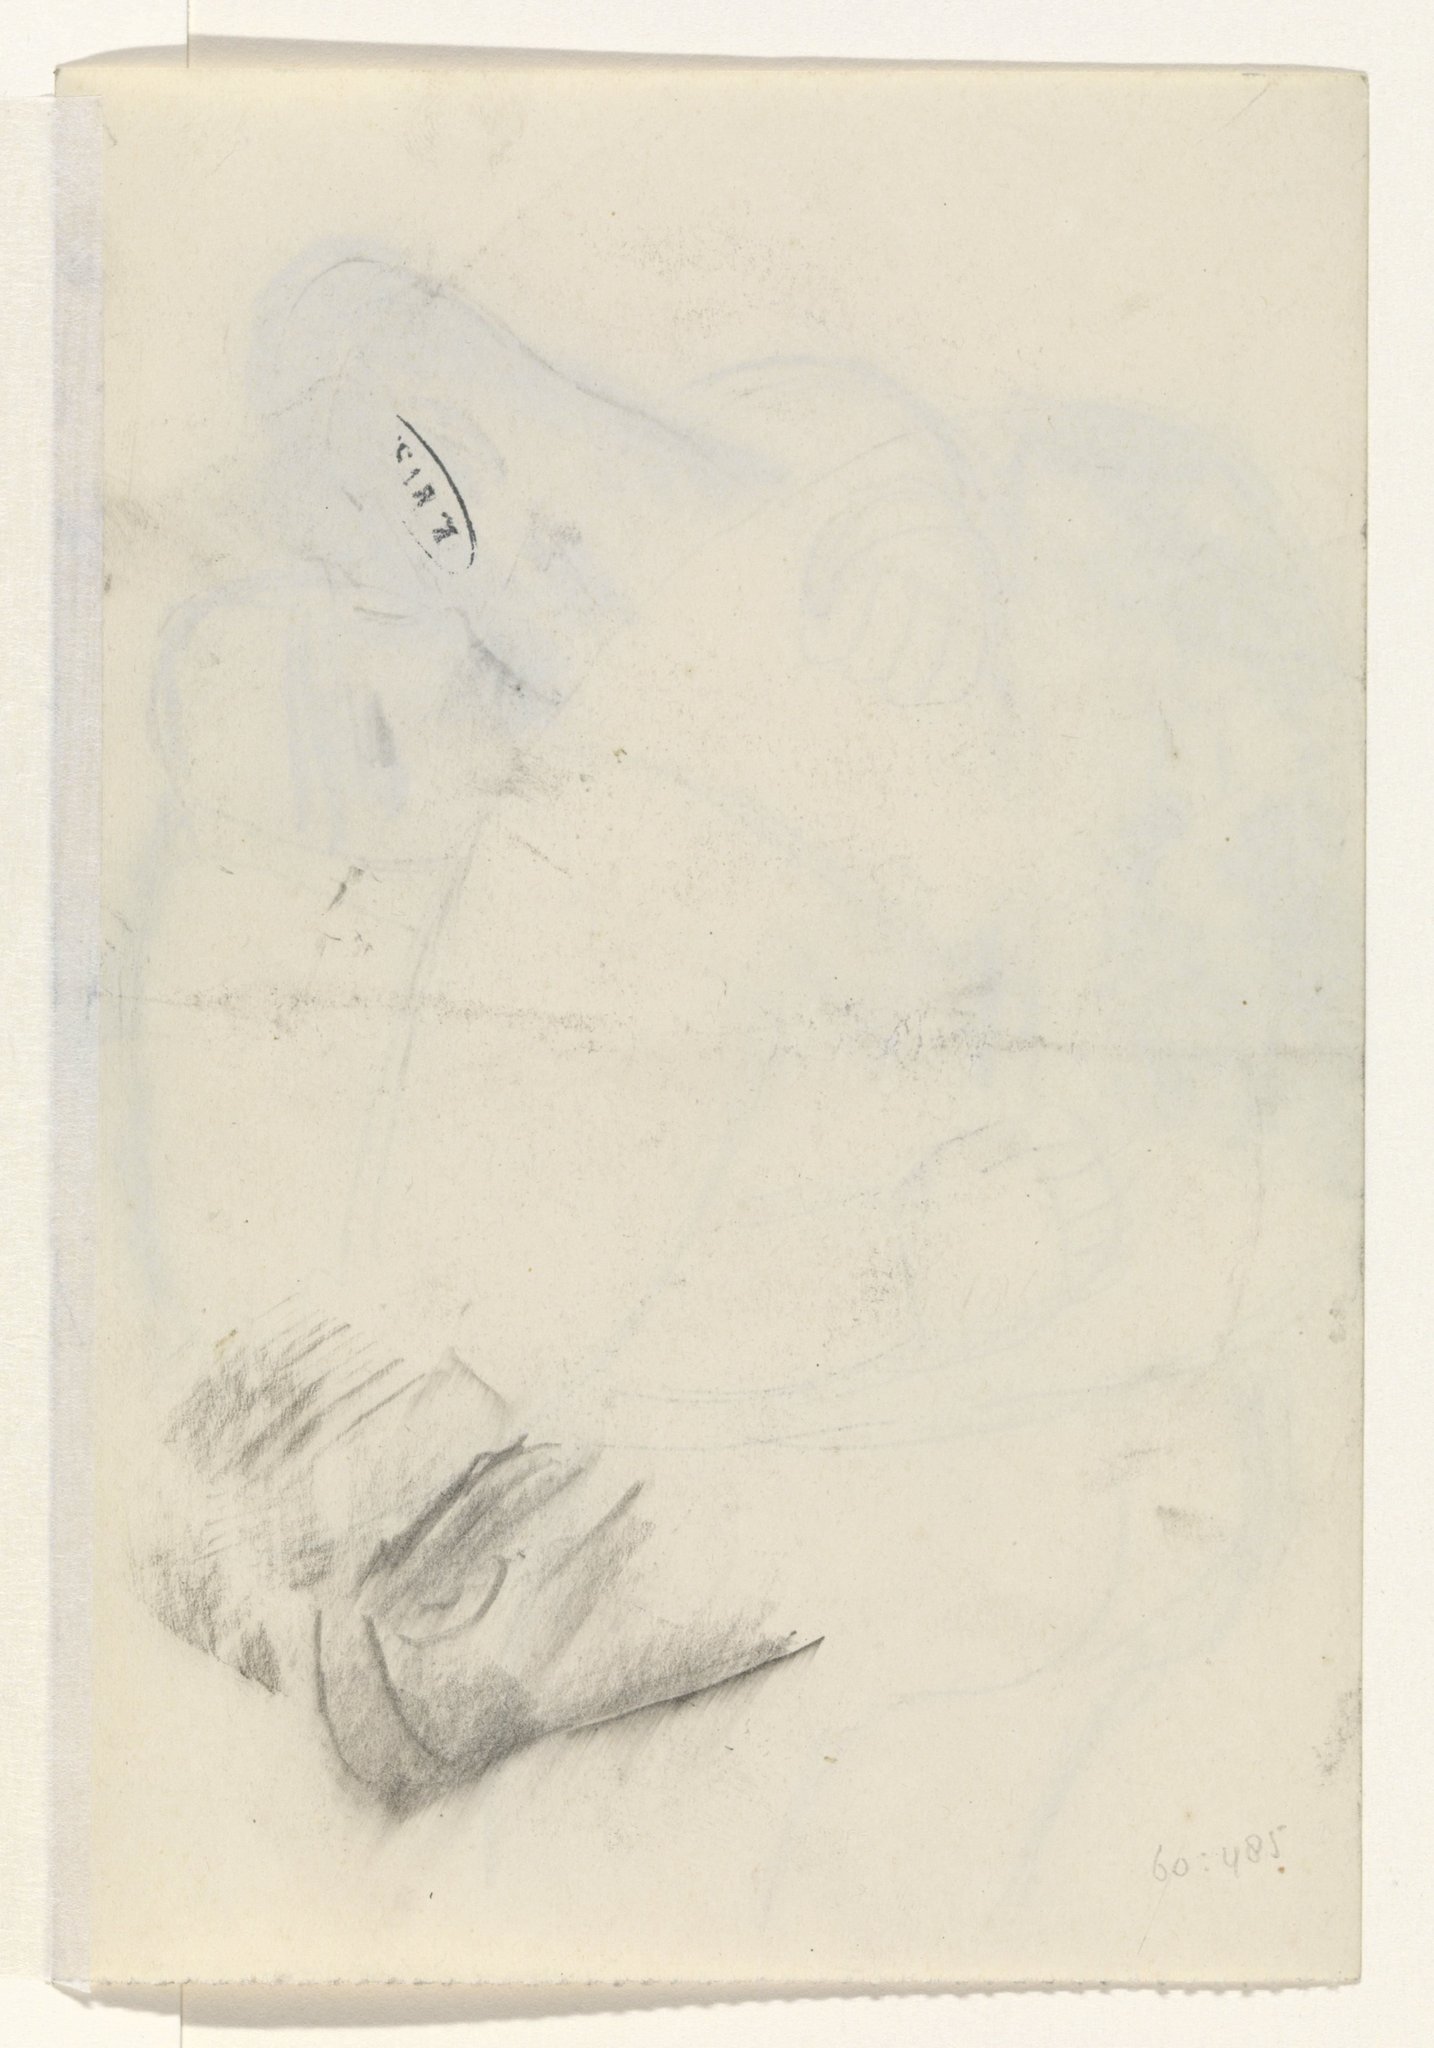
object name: drawing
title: Hoofden van een kussend stel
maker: leo gestel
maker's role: draughtsman, print maker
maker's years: 1881-1941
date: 1891-1941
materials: paper, pencil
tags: (lovers) kissing each other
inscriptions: collector's mark: Lugt 2228